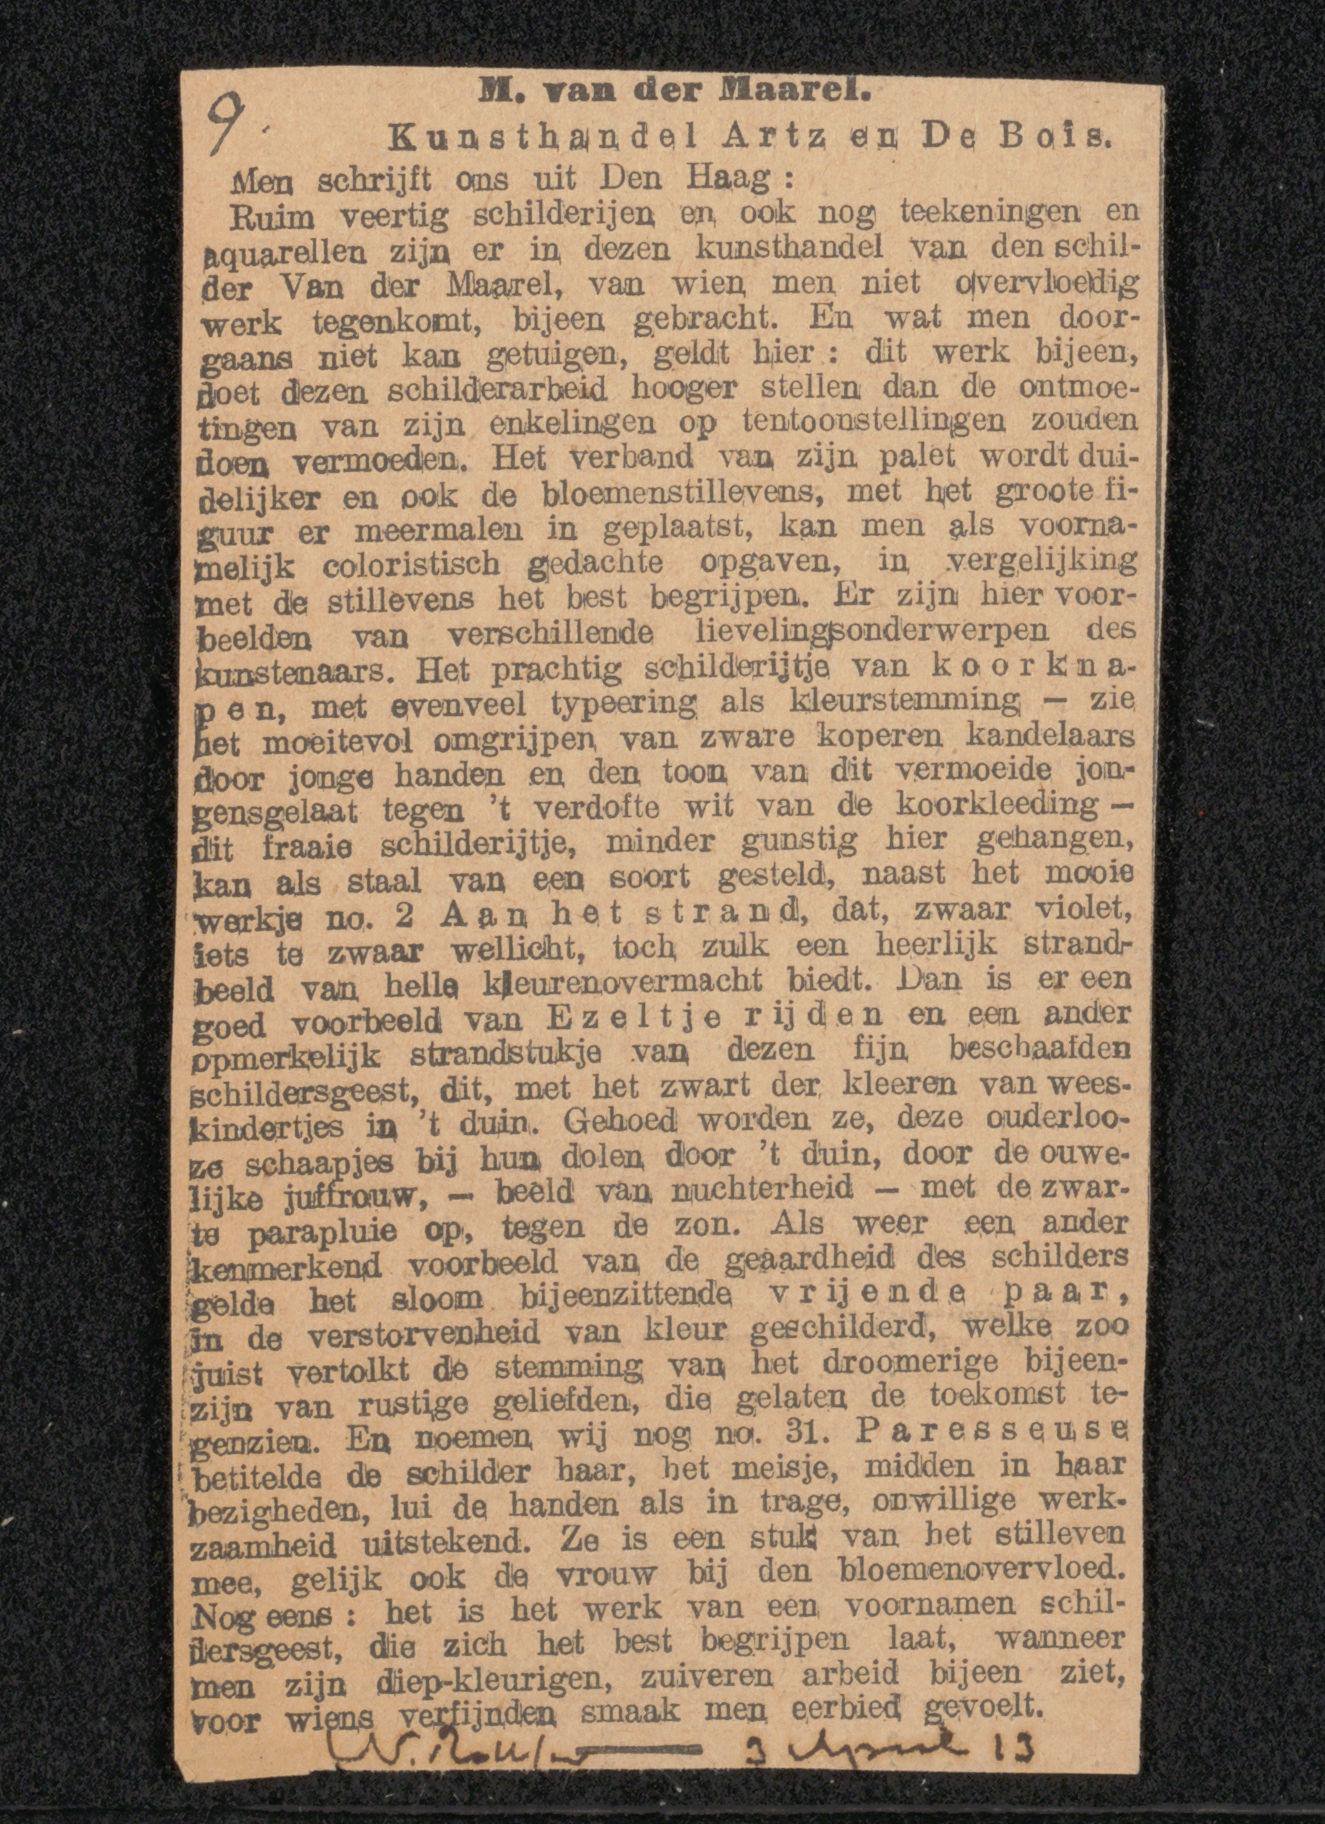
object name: newspaper clipping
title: Krantenknipsel betreffende Marinus van der Maarel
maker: Anonymous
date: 1913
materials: paper, ink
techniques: printing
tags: the hague, painter, draughtsman, marinus van der maarel